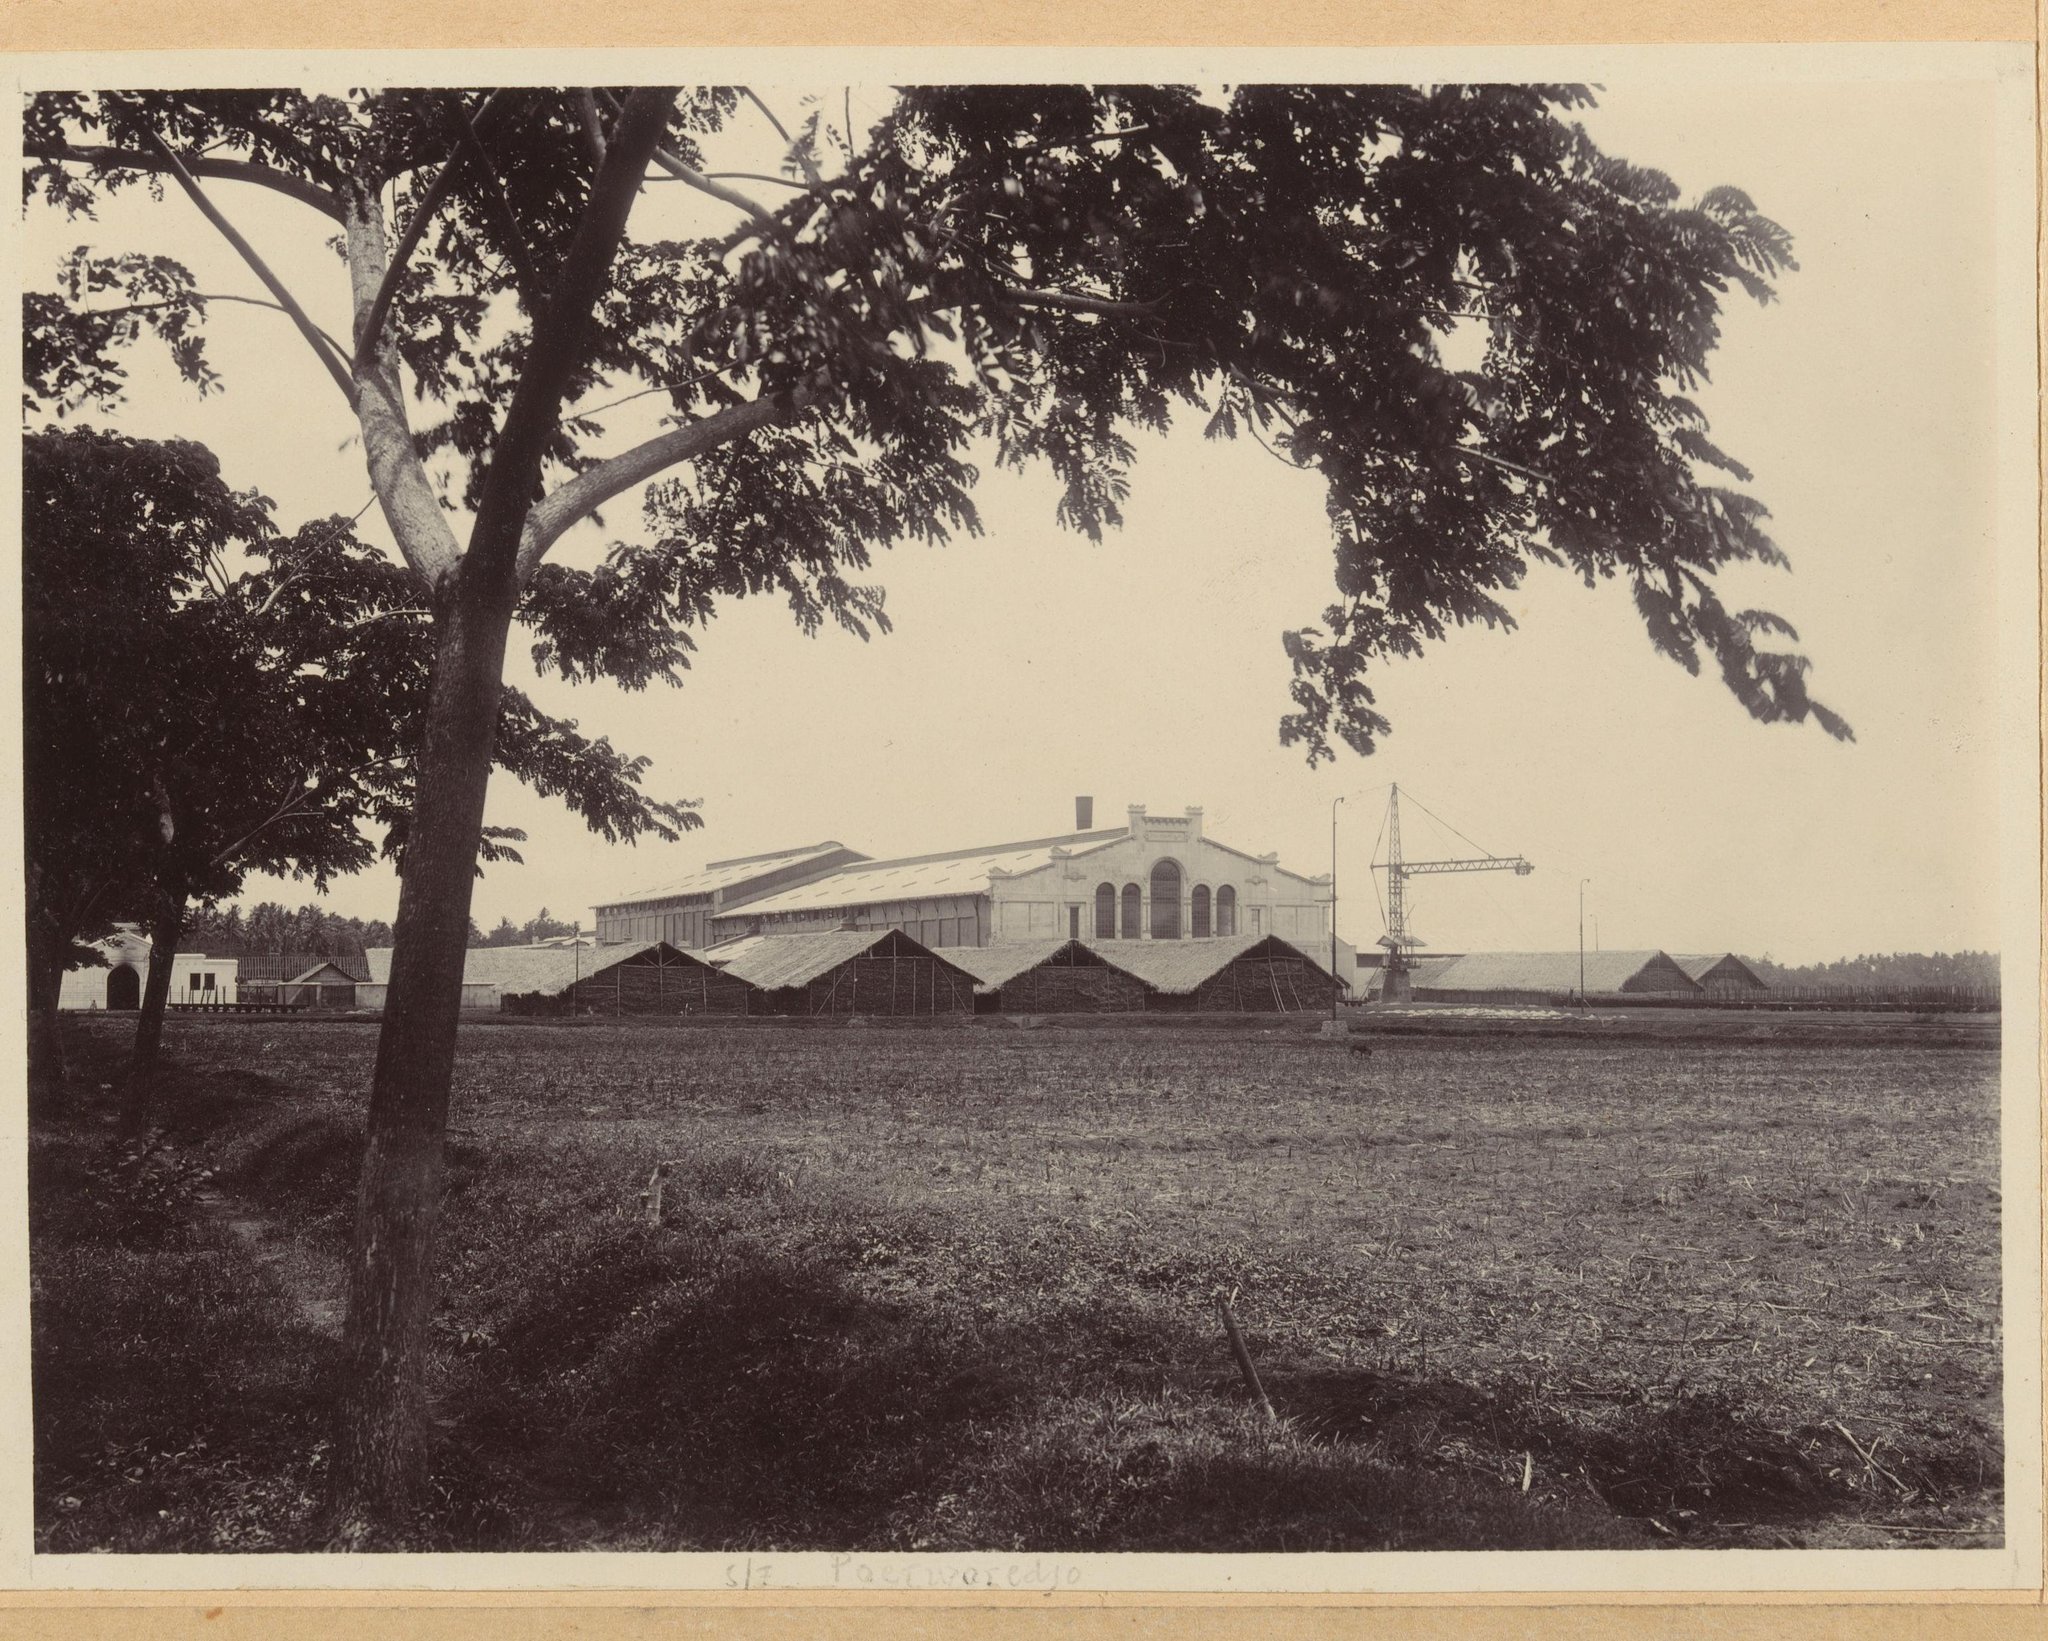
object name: photograph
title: Suikerfabriek met hijskraan in Purworejo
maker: Anonymous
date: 1916-1918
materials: photographic support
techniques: gelatin silver print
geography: purworejo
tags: factory-building, vertical transport, hoisting (industrial processes), factory in landscape, dutch east indies, the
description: Onderdeel van Familiealbum met foto's van een familie in de voormalige kolonie Nederlands-Indië en van een suikerfabriek in Purworejo.